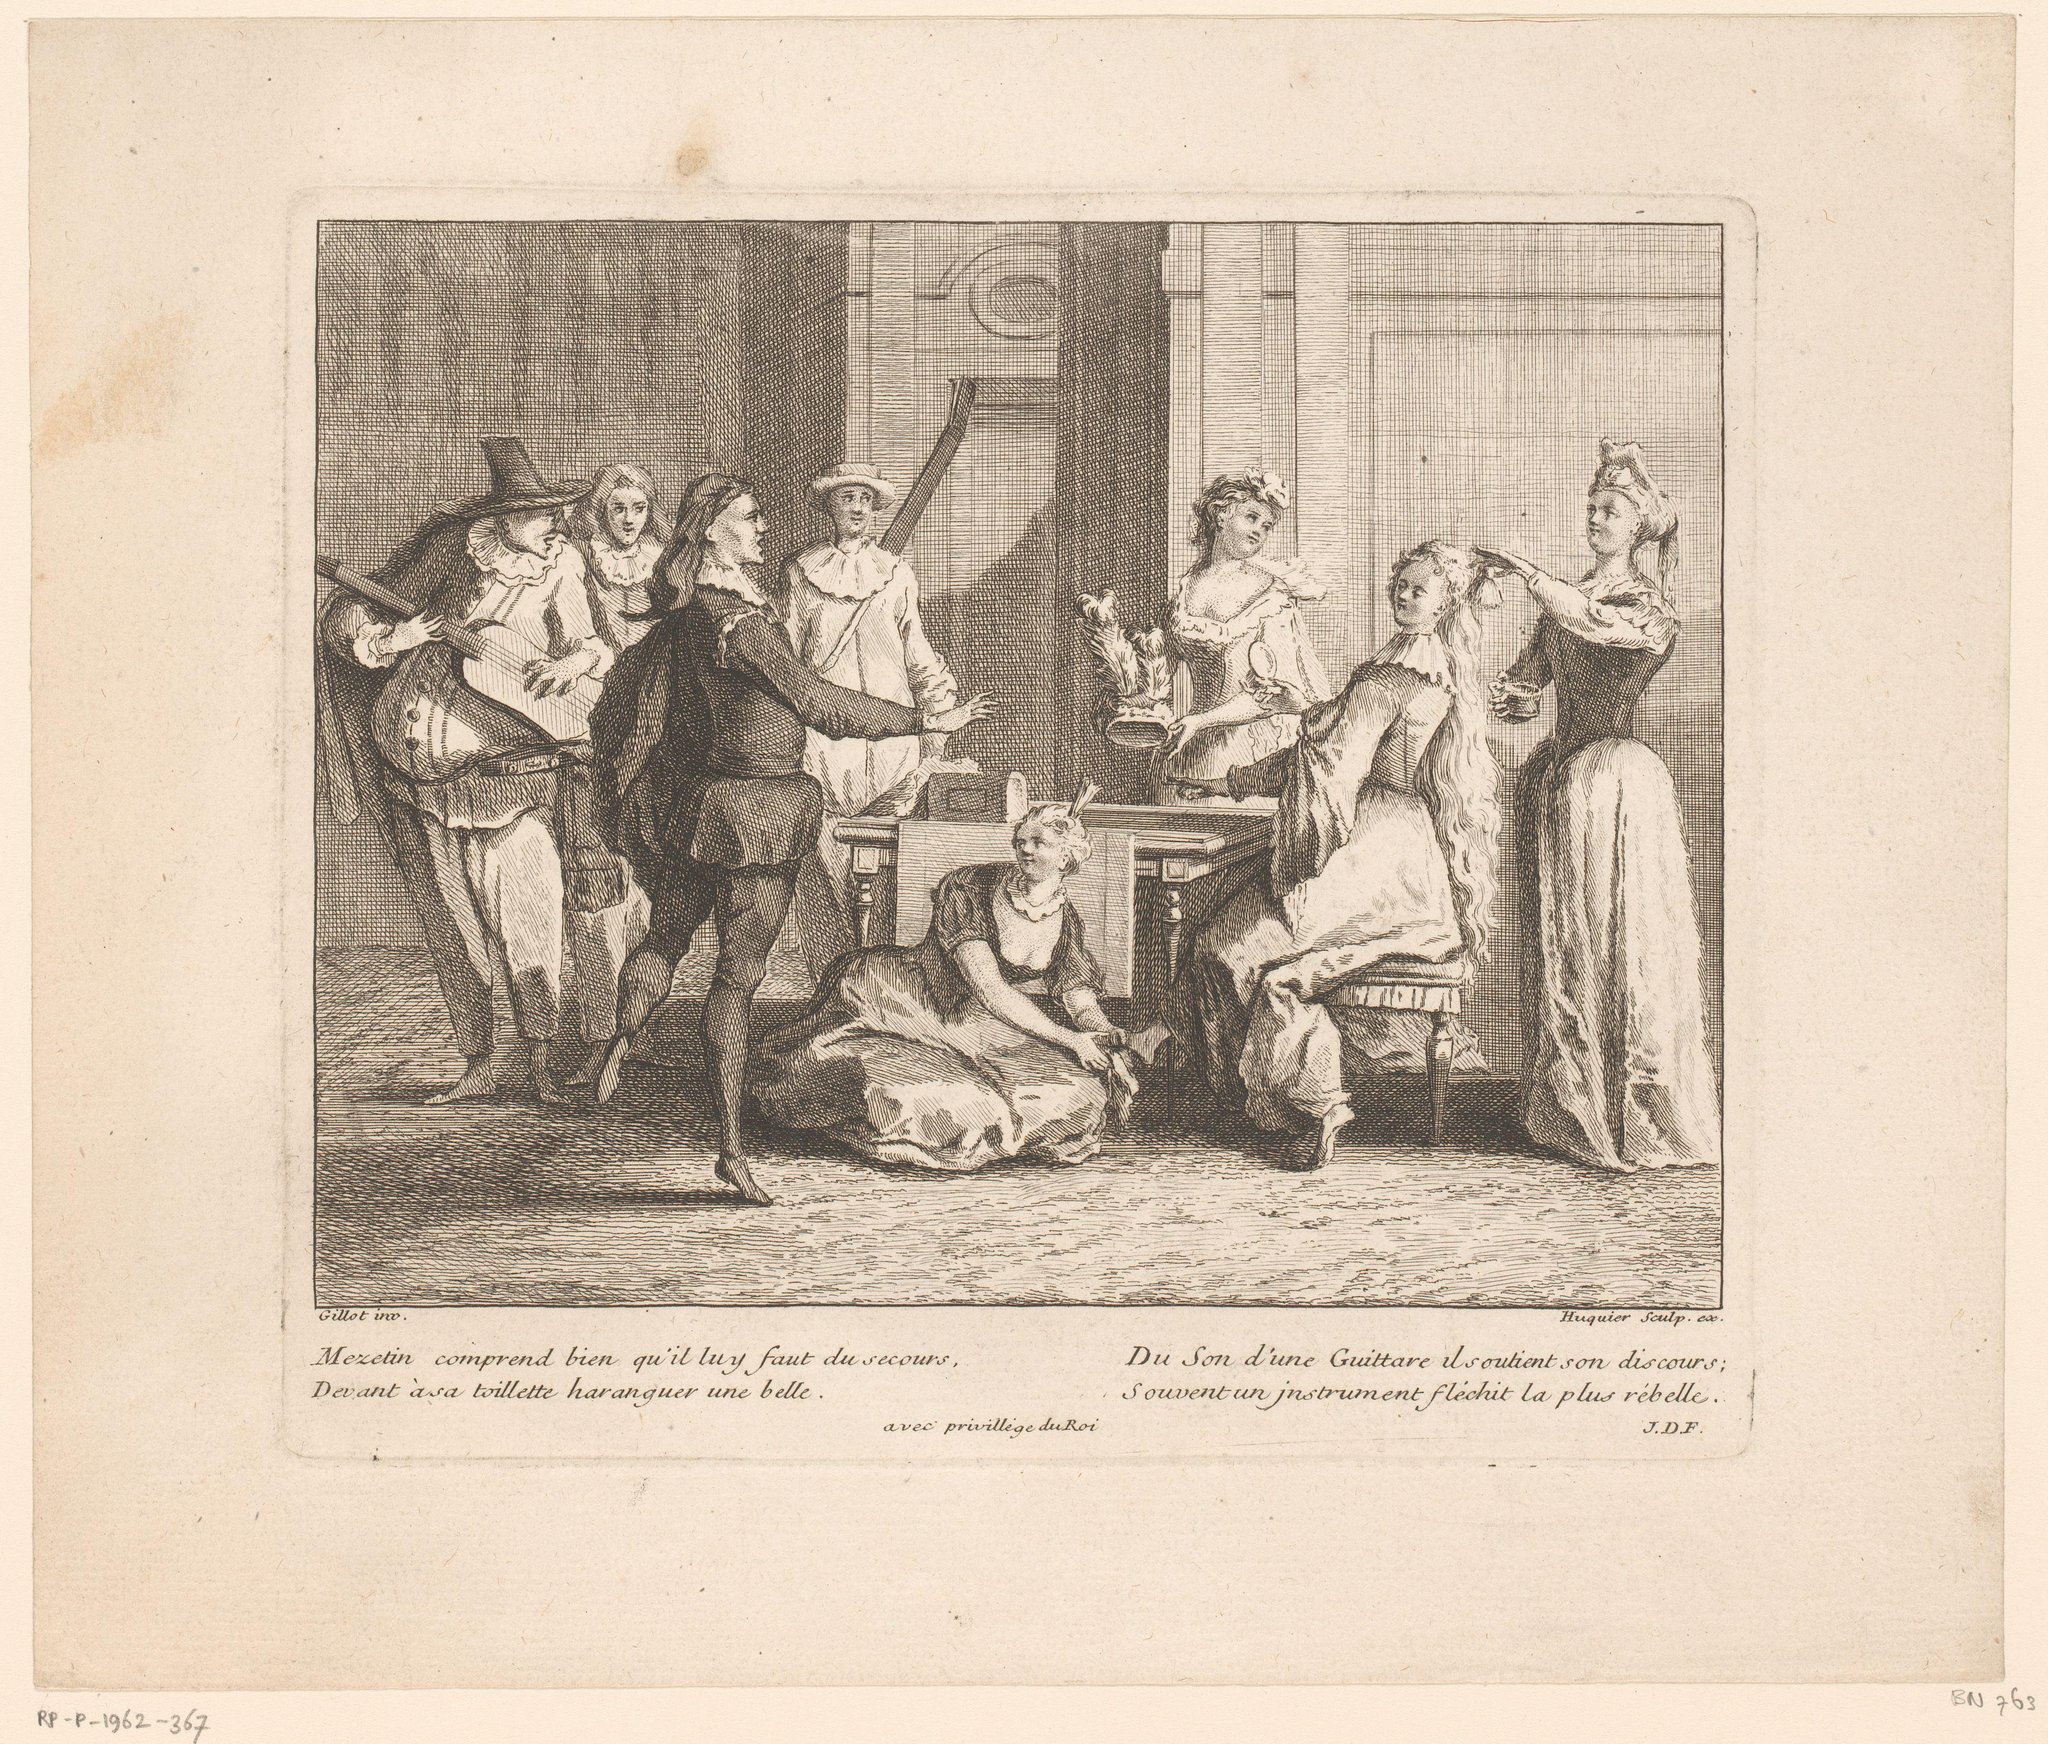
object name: print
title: Scènes uit de Commedia dell'arte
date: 1729-1732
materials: paper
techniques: etching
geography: france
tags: types in 'commedia dell'arte'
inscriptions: collector's mark: Lugt 2228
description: Maakt deel uit van een serie van twaalf prenten met scènes uit de Commedia dell'arte door Huquier naar tekeningen door Gillot. De serie werd tussen 1729 en 1732 uitgegeven door Huquier en de weduwe van François Chéreau.